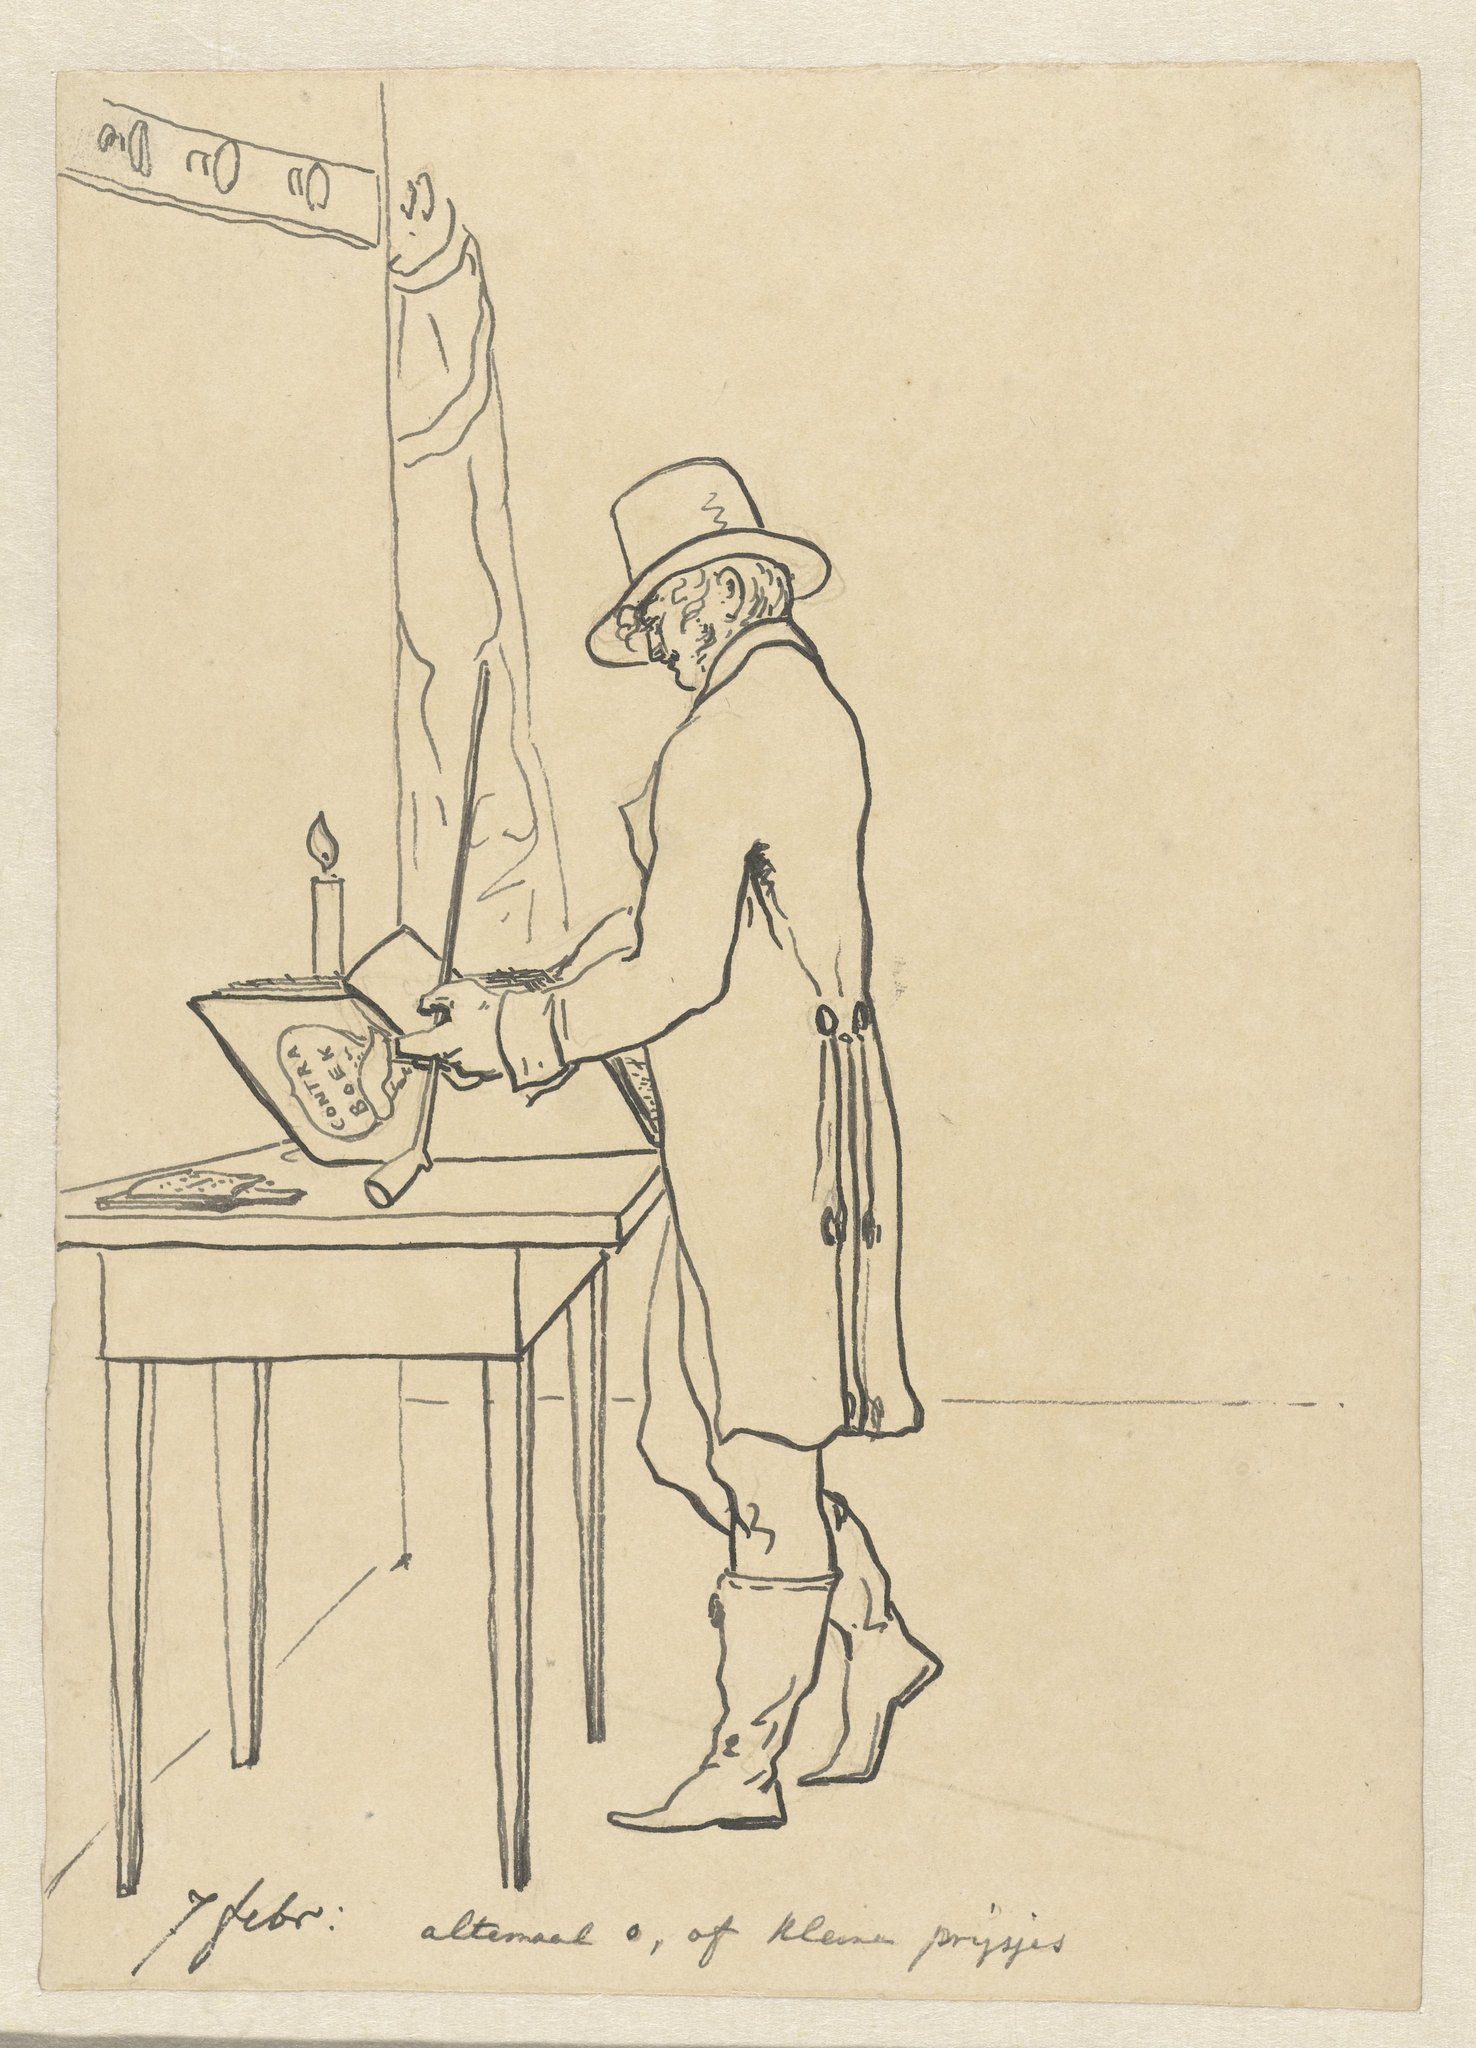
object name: drawing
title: Altemaal o, oft kleine prijsjes (dagboek, 7 februari)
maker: christiaan andriessen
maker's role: draughtsman, print maker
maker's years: 1775-1846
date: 1805-1808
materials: ink, paper, pencil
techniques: pen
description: Blad uit het getekende dagboek dat Christiaan Andriessen bijhield van 1805 tot en met 1808.